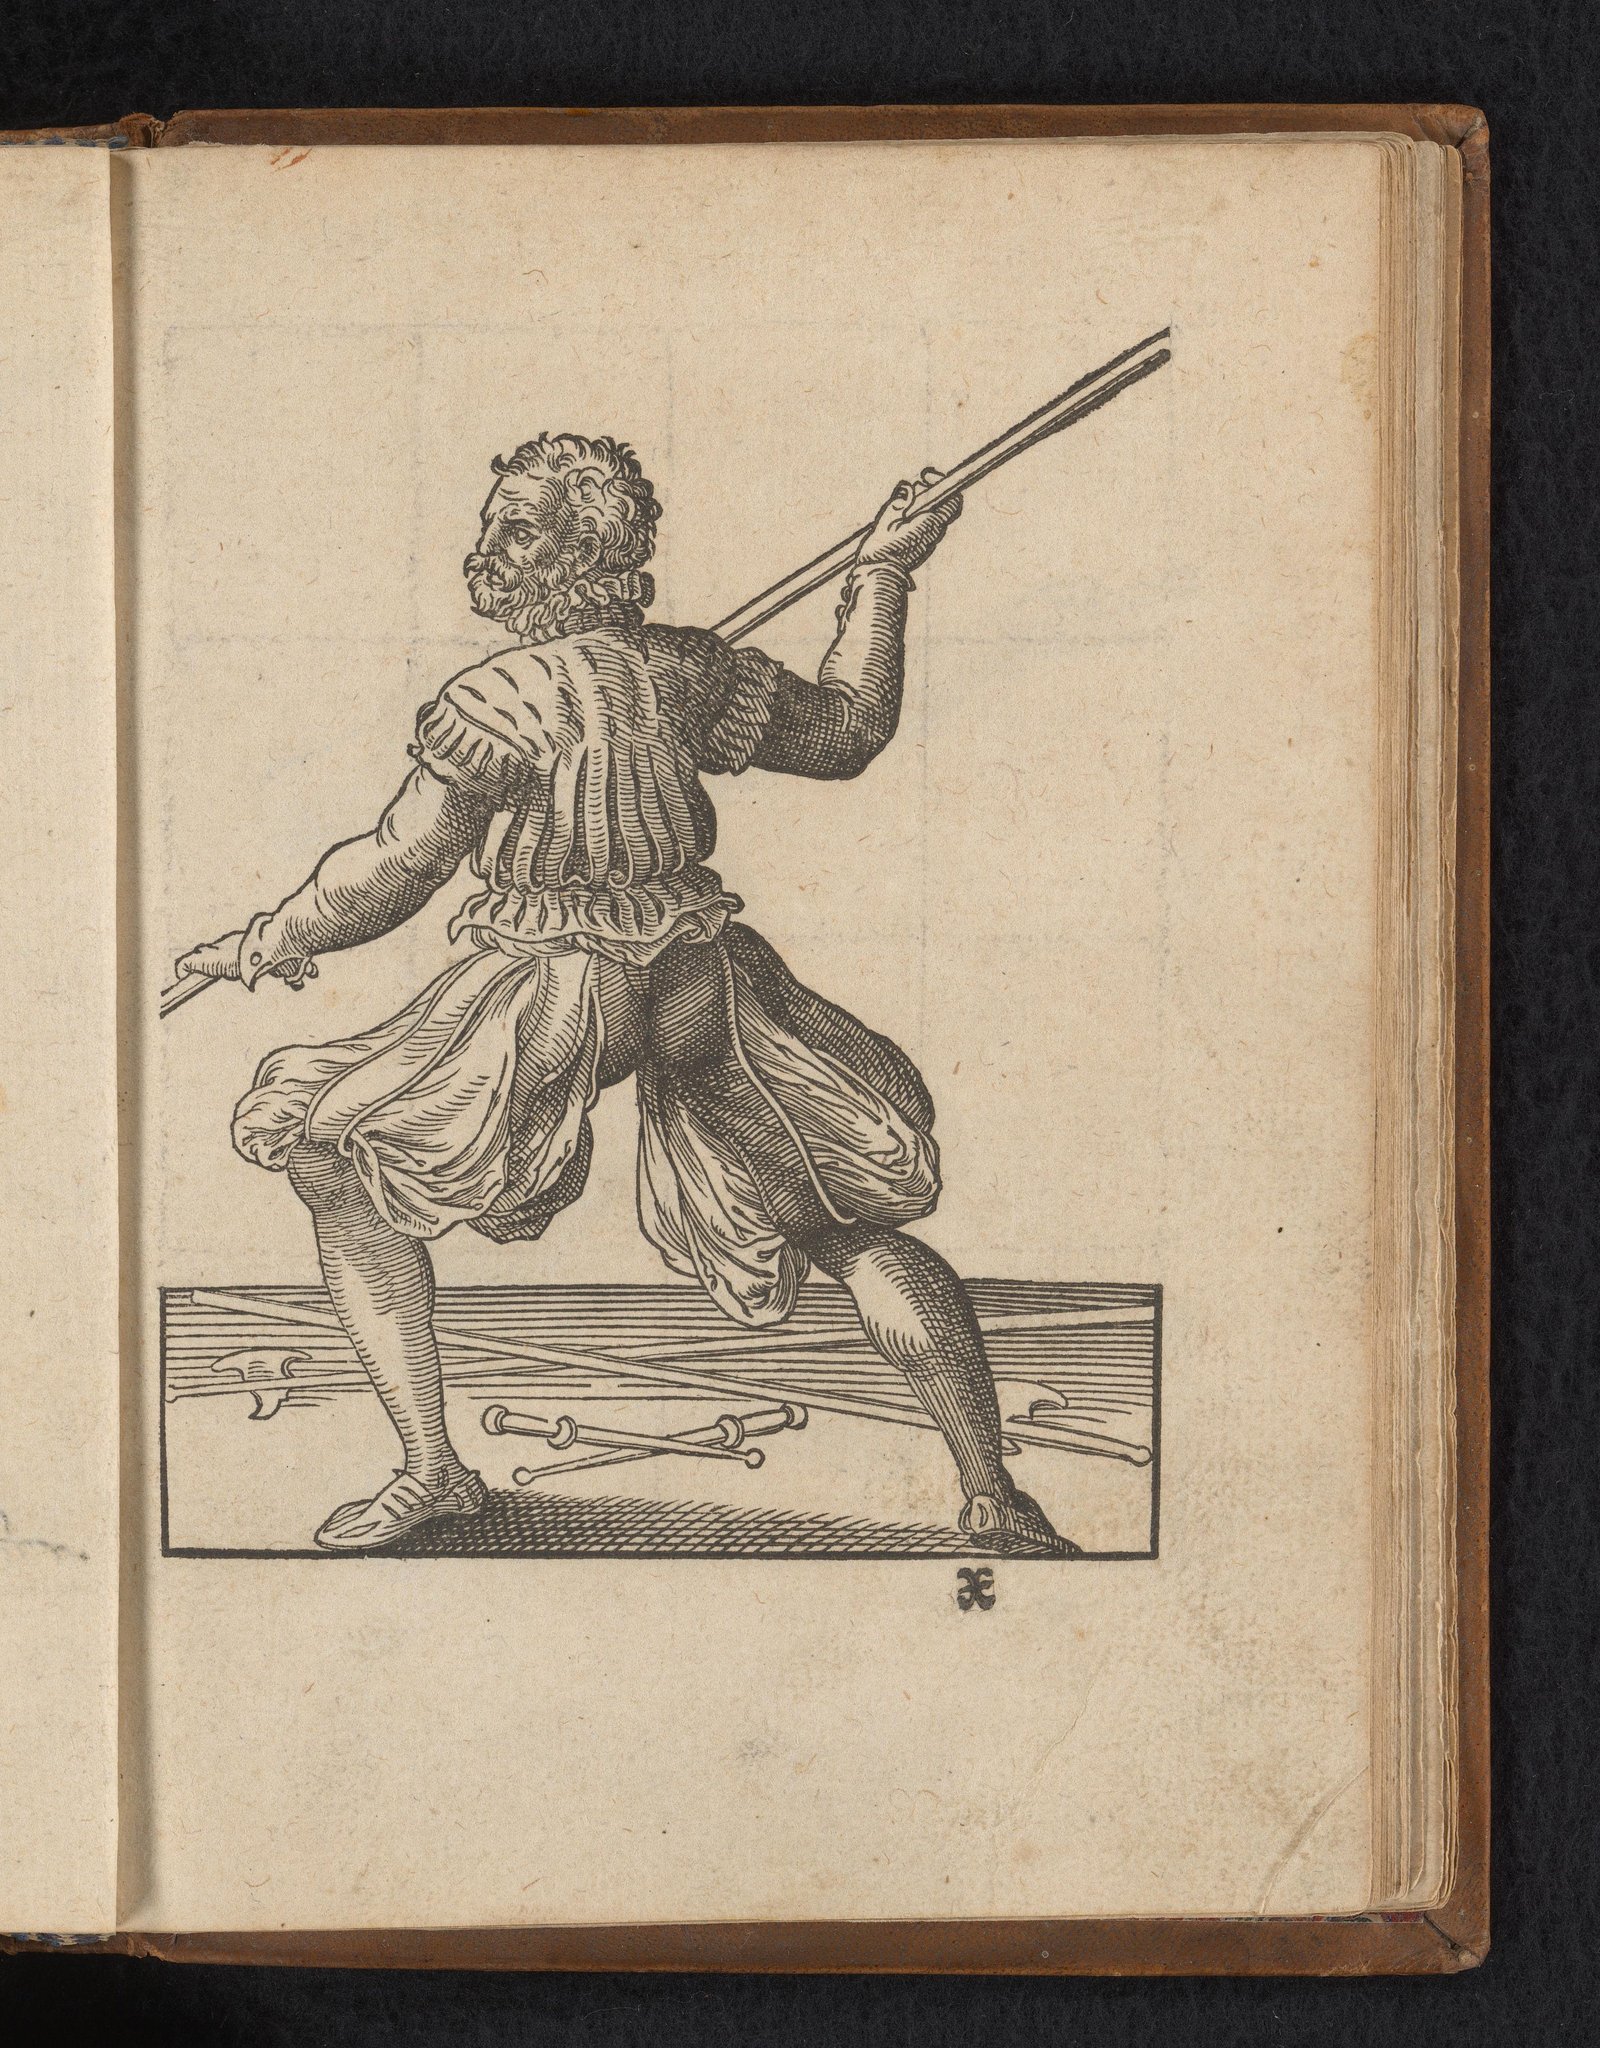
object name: print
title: Wapenoefening met een lans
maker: Anonymous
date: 1578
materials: paper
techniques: woodcut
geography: nuremberg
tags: handling of weapons ~ military training (+ infantry)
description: Wapenoefening met een lans, naar links. Onderdeel van het modelboek Enchiridion artis pingendi, fingendi & sculpendi met 108 figuren bedoeld voor beginnende schilders, beeldhouwers en prentmakers.